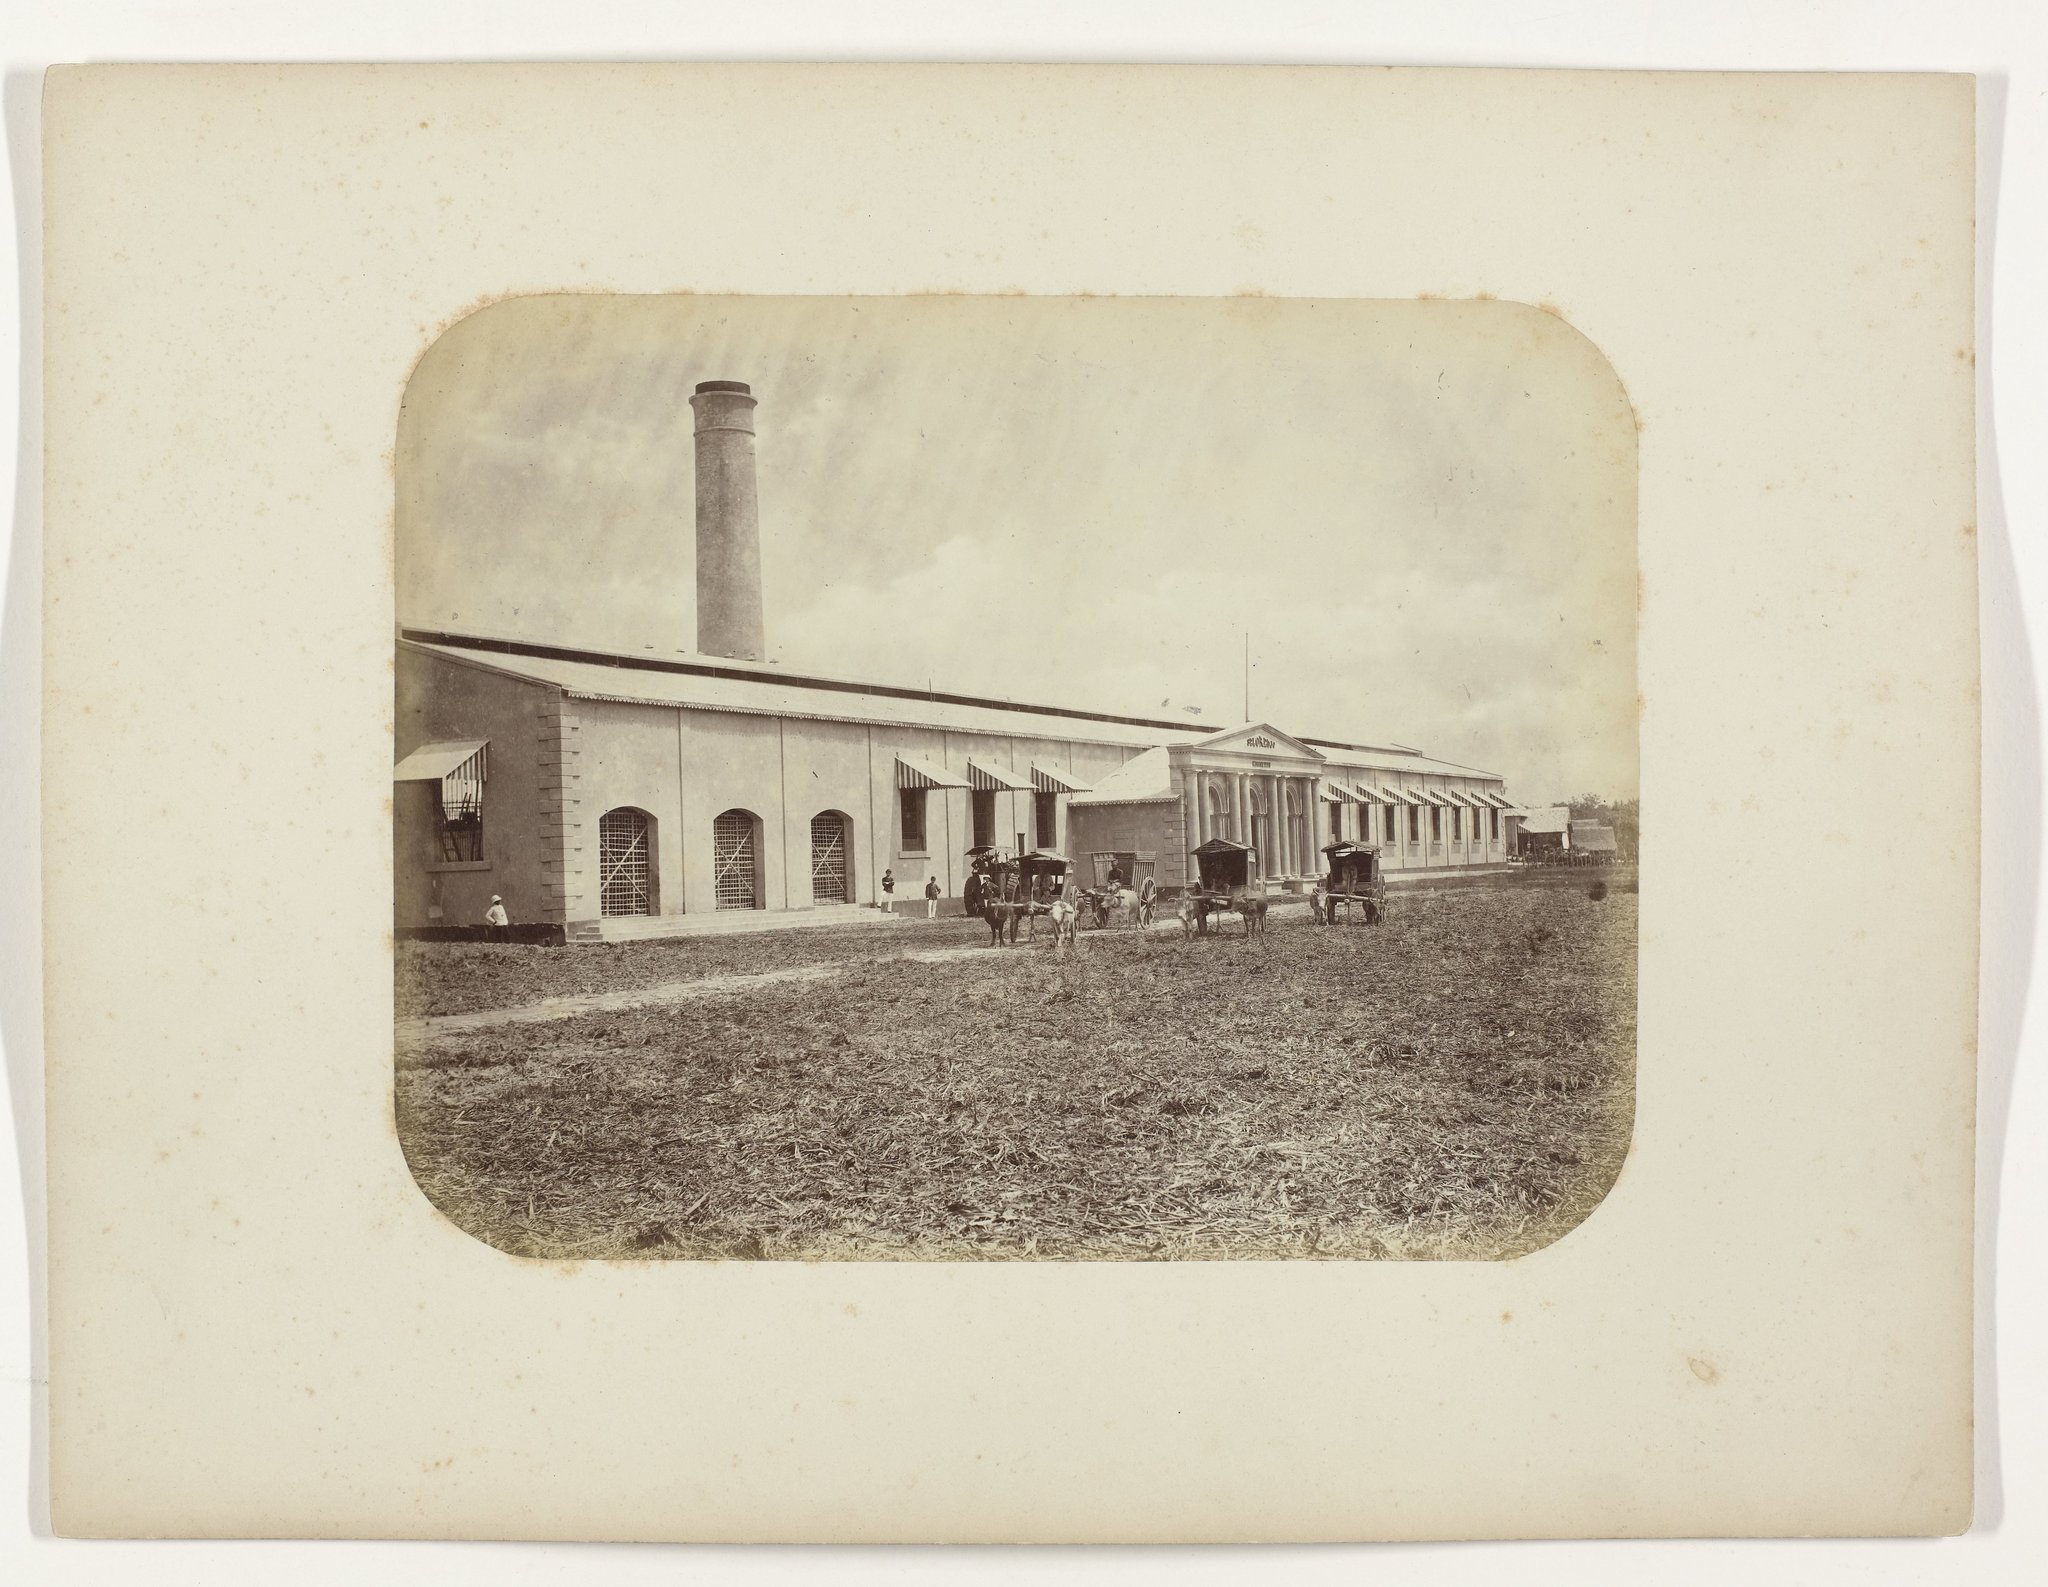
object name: photograph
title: Suikerfabriek Seloredjo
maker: herman salzwedel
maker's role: fotograaf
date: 1876-1884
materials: photographic support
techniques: albumen print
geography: surabaya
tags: utrecht, the hague, colonial system, factory-building, (non-fruit) products of plants or trees: sugarcane, surabaya, java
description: Een suikerfabriek met boven de bezuilde ingang het opschrift Seloredjo en daaronder in romeinse cijfers het jaartal 1882. Op de fabriek links een schoorsteenpijp. Voor de fabriek een grasveld met vier ossenkarren en een traktor. Op iedere door ossen getrokken karren een inlander, op de traktor een Europeaan. Onderdeel van het fotoalbum door de Soerabayasche Vereeniging van Suikerfabrikanten aangeboden aan Frederik Beyerinck, resident van Soerabaja.